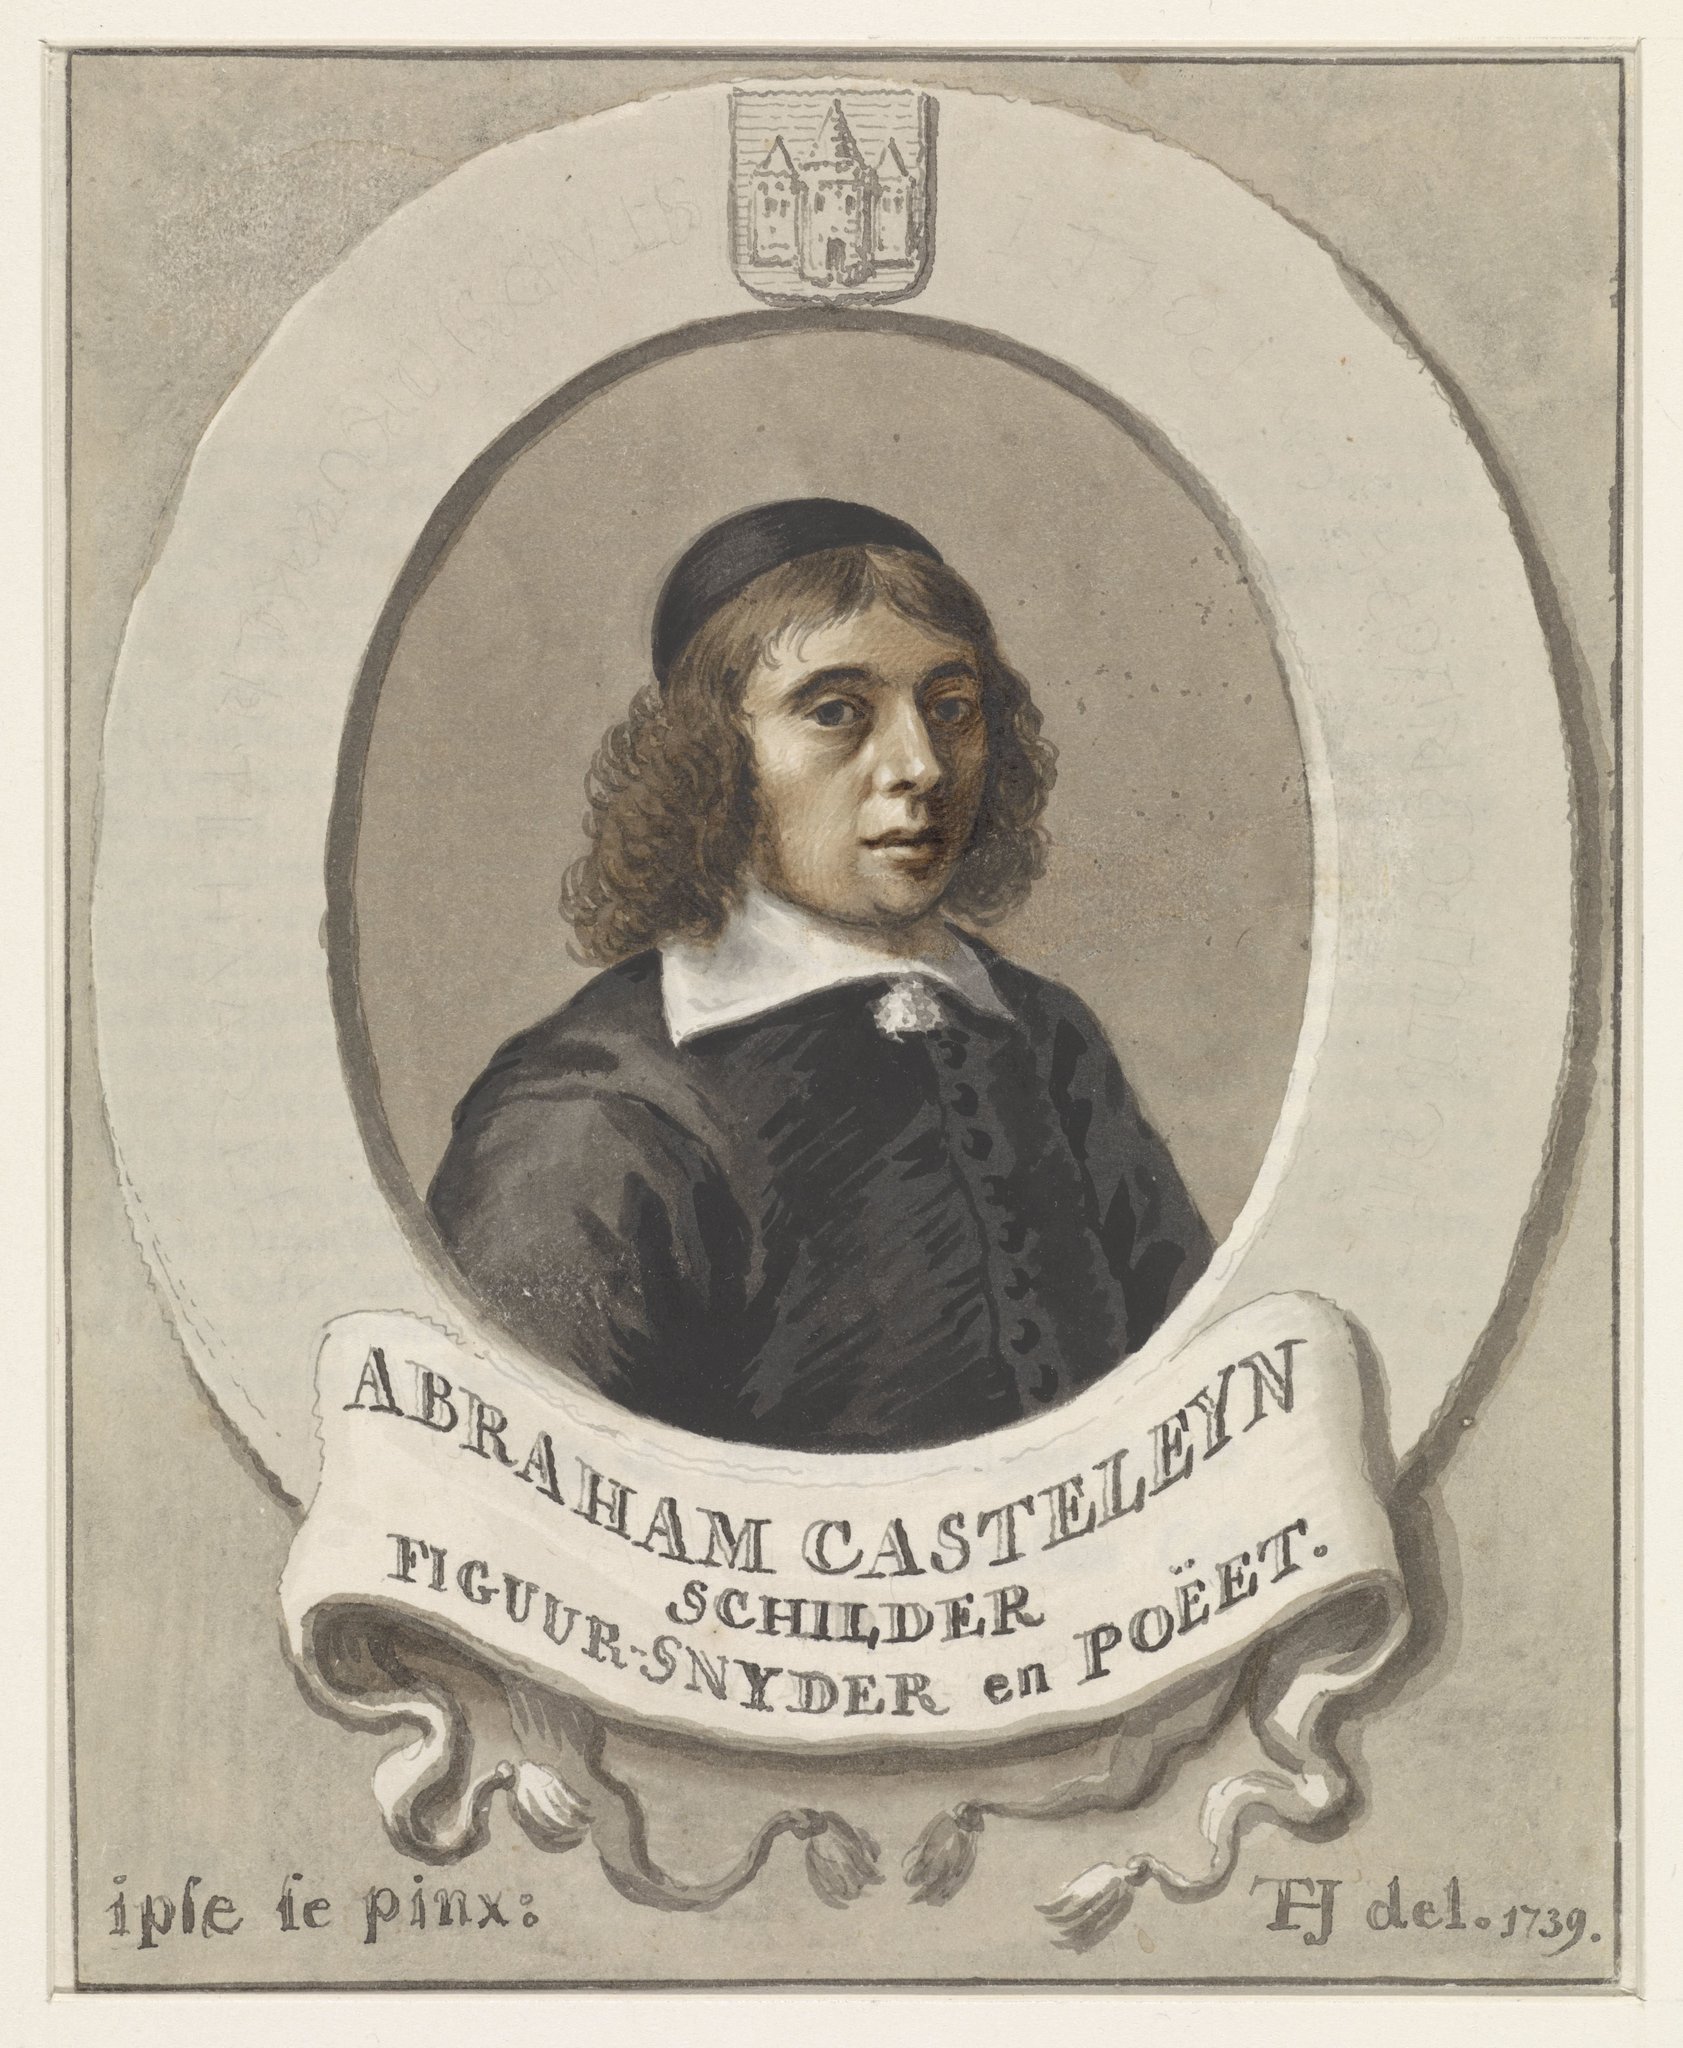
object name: drawing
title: Portret van Abraham Casteleyn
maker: tako hajo jelgersma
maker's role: draughtsman, painter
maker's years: 1702-1795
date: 1739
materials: paper, watercolor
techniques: brush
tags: printer, publisher, abraham casteleyn, historical persons, portrait, self-portrait of painter, portrait, self-portrait of artist, portrait, self-portrait of draughtsman